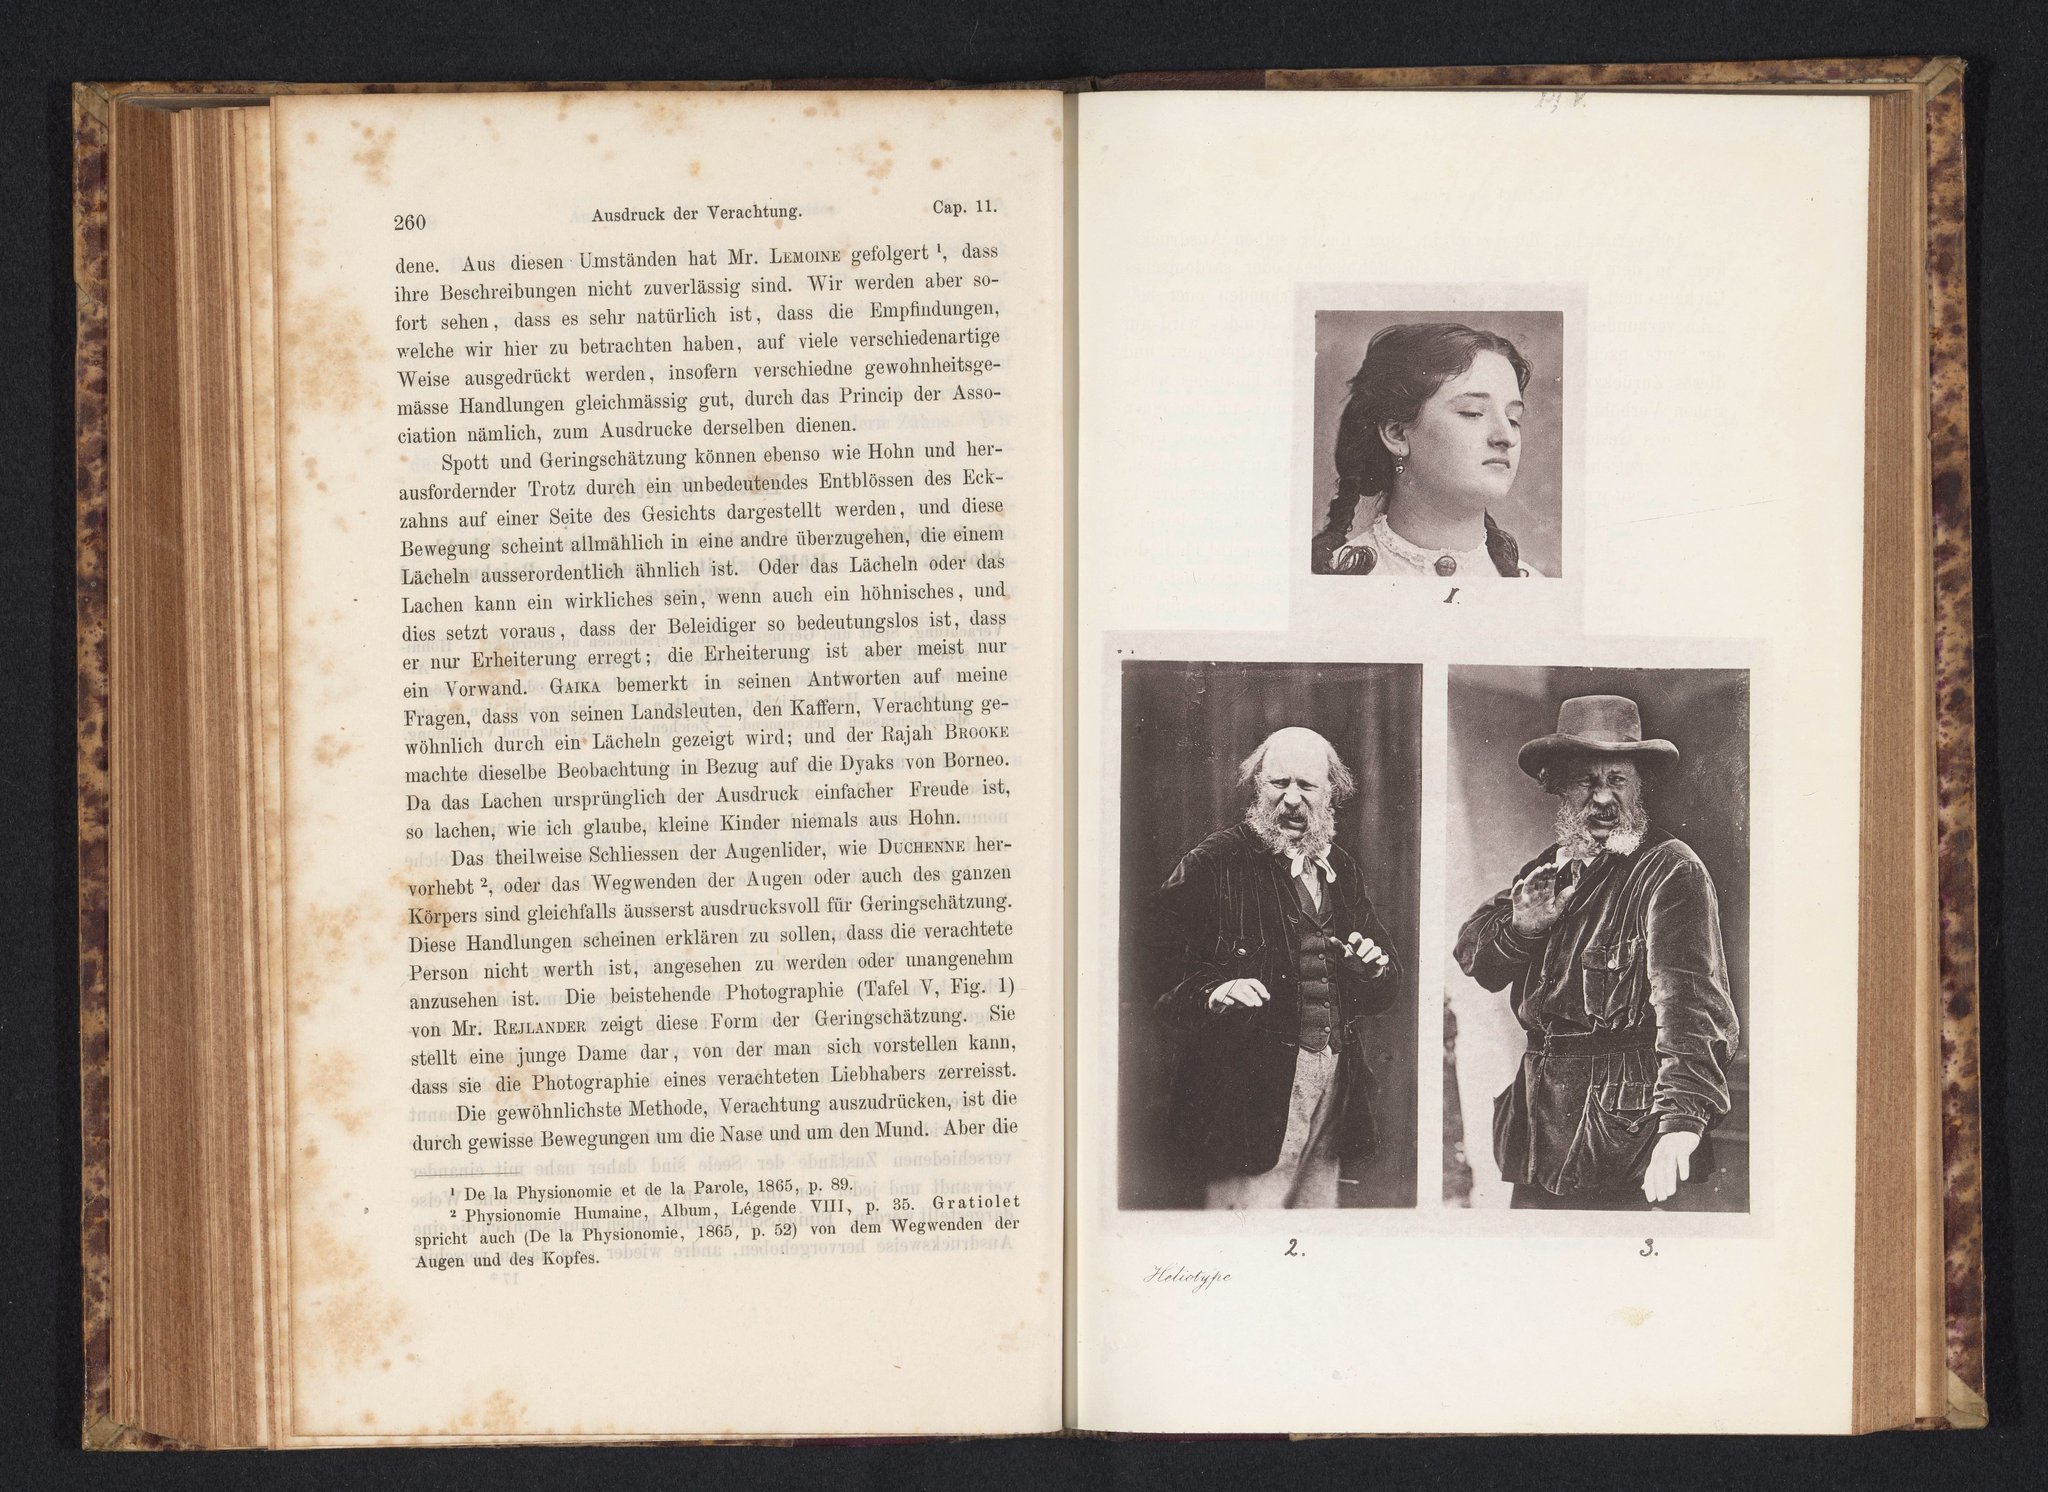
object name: page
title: Drie portretten van onbekende mannen en een vrouw die minachting tonen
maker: Anonymous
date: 1862-1872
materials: paper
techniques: photoaquatint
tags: passions, emotions, affections, contempt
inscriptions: number: ‘Pl. V. 1. 2. 3.’